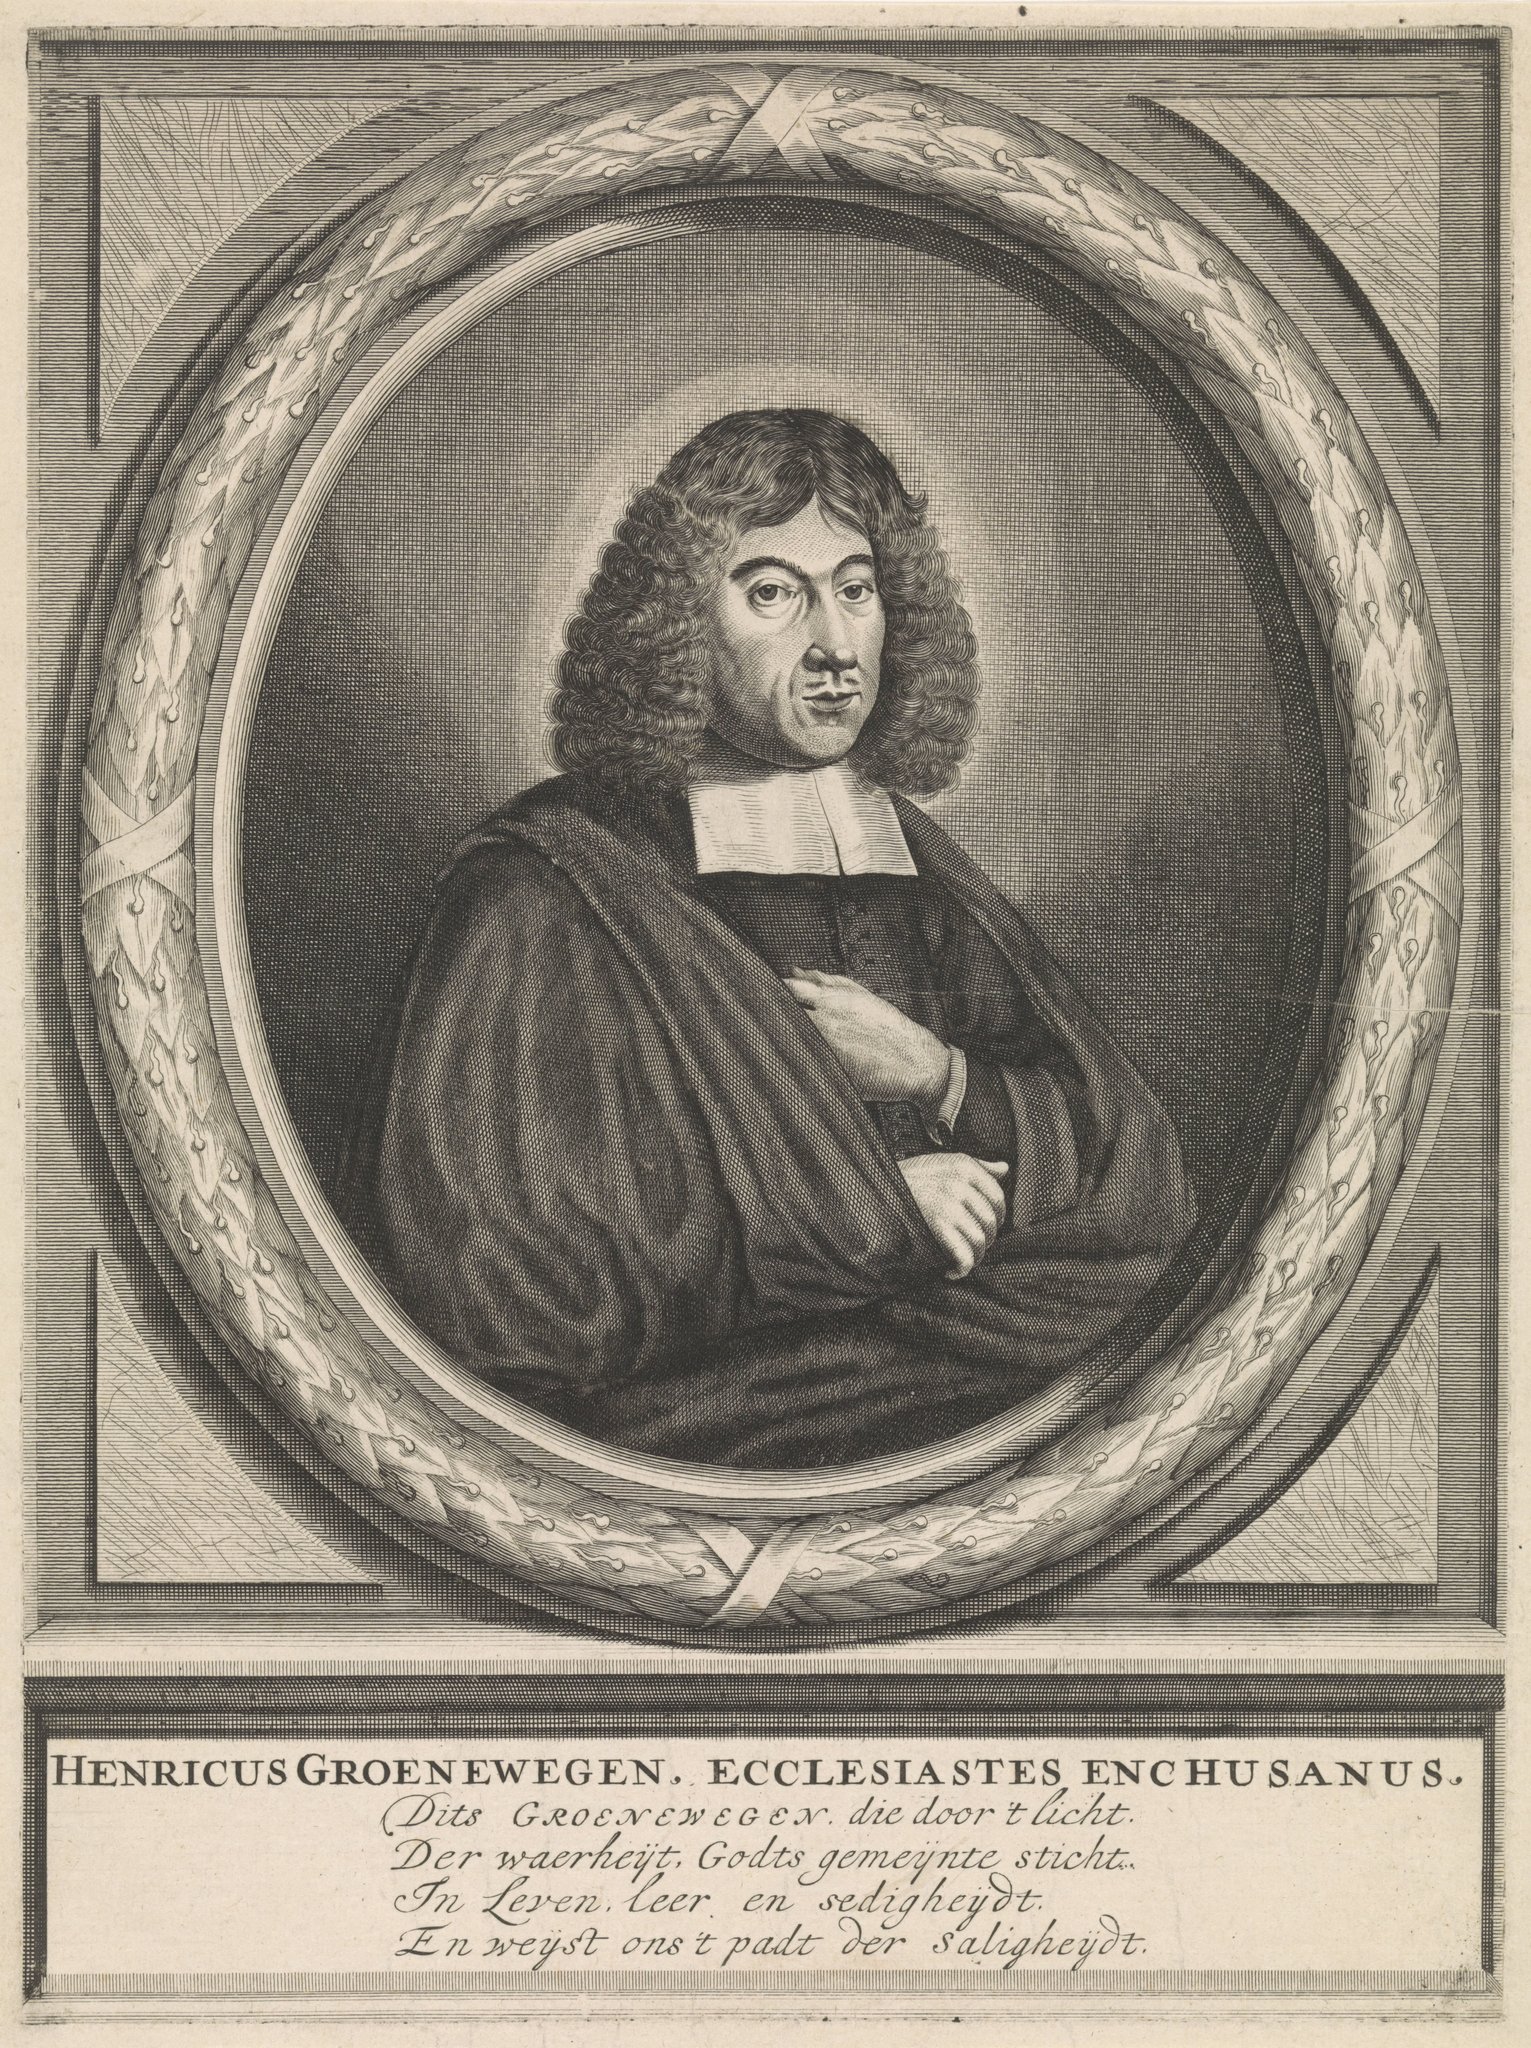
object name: print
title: Portret van de predikant Henricus Groenewegen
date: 1694-1715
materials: paper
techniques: engraving, etching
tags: enkhuizen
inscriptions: collector's mark: Lugt 2228